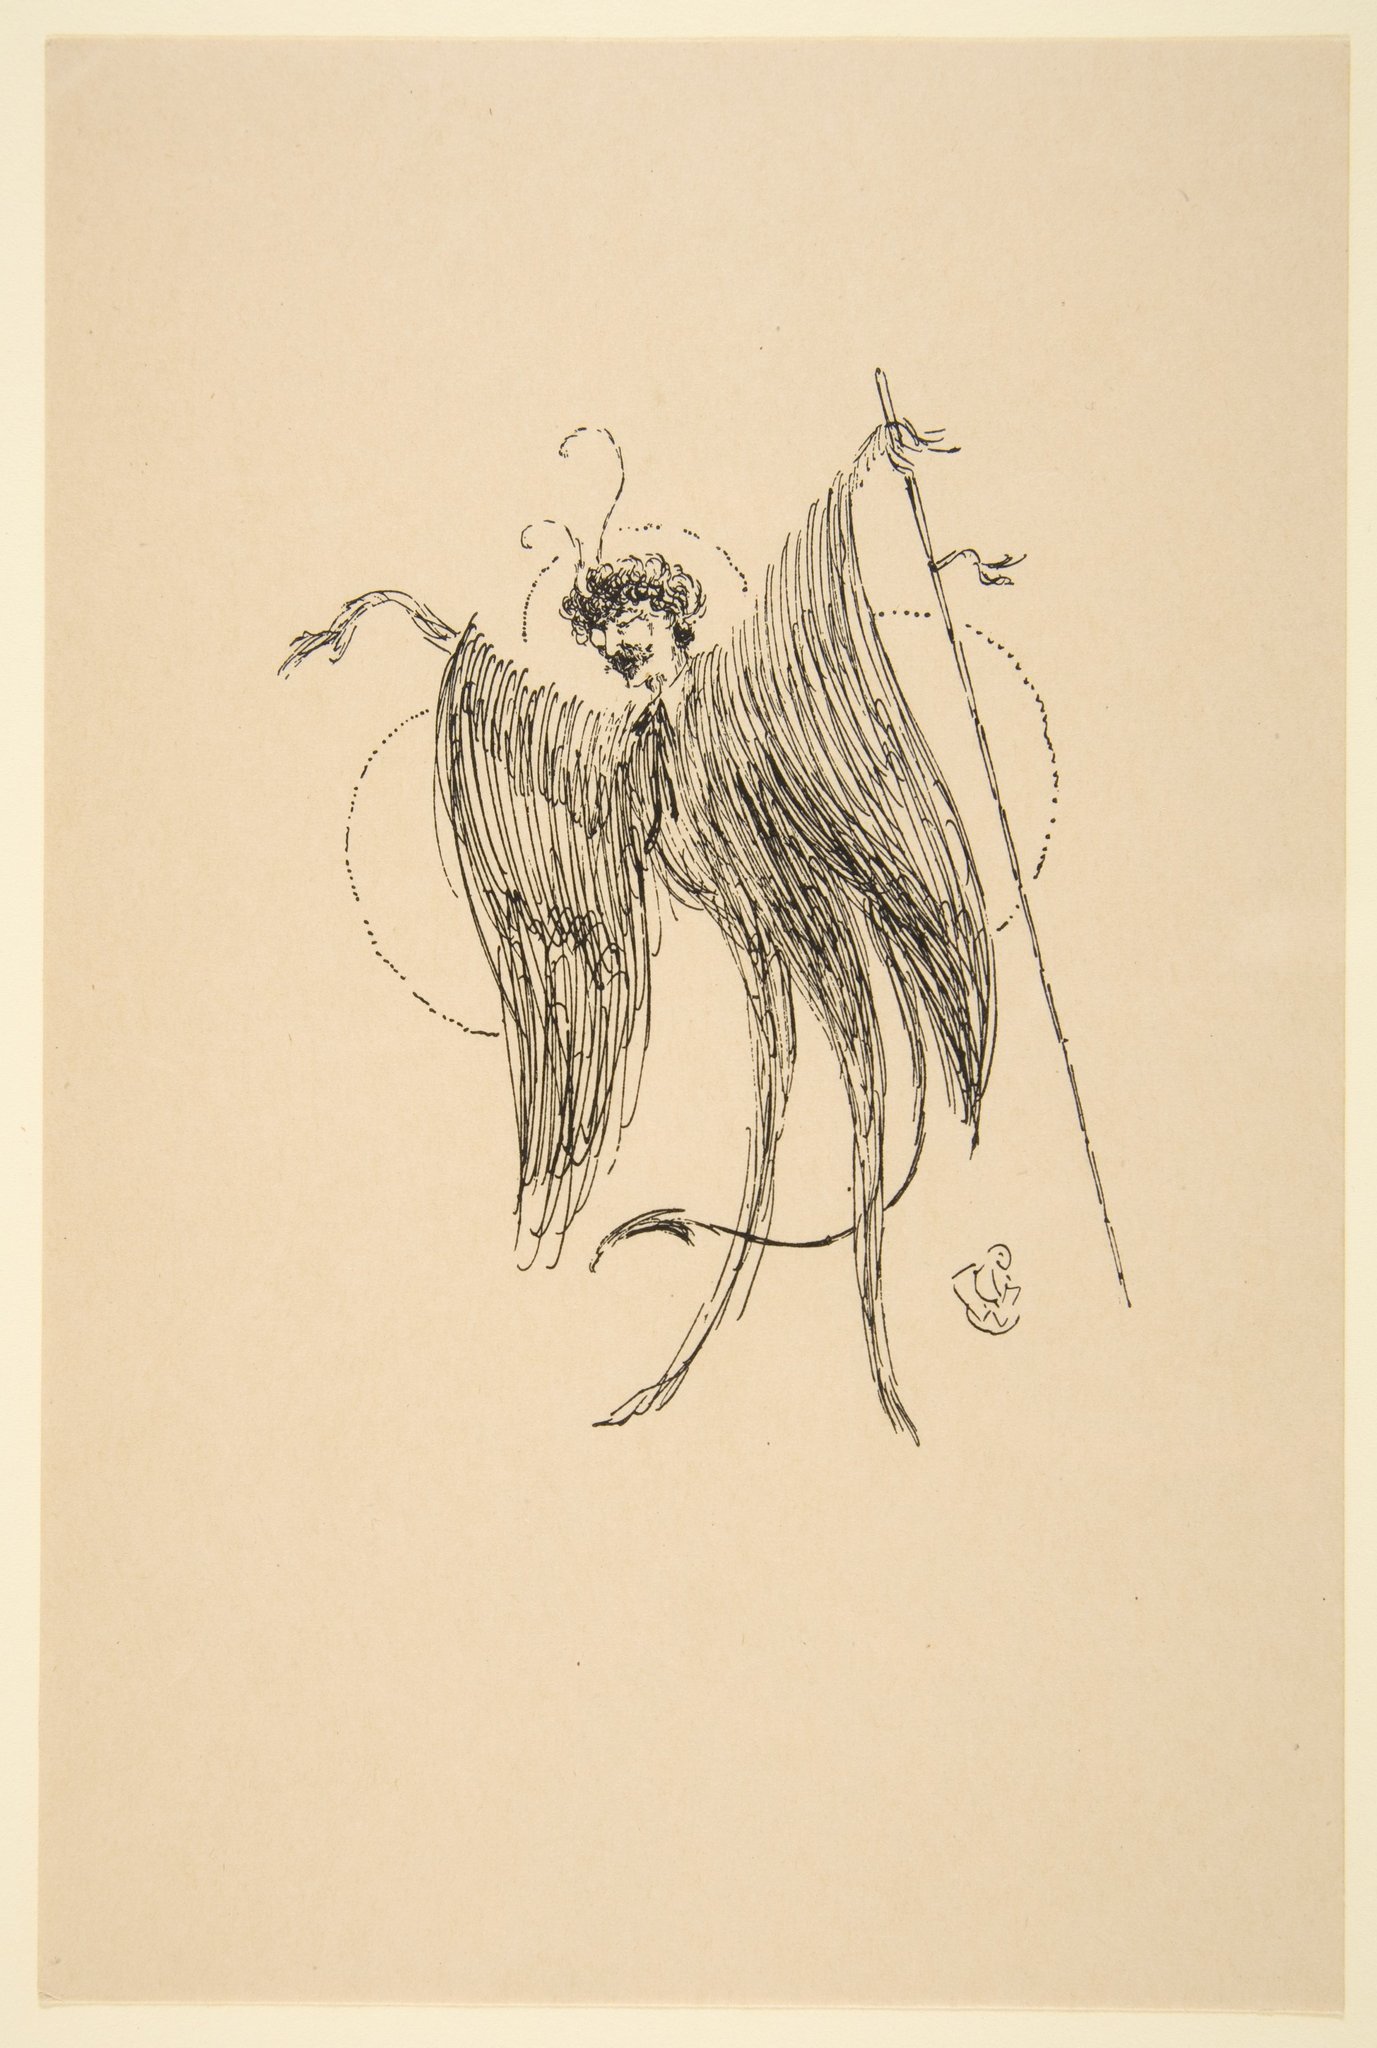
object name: print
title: Whistler as Butterfly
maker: james mcneill whistler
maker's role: sitter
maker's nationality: american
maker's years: 1834-1903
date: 1801-2000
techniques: relief